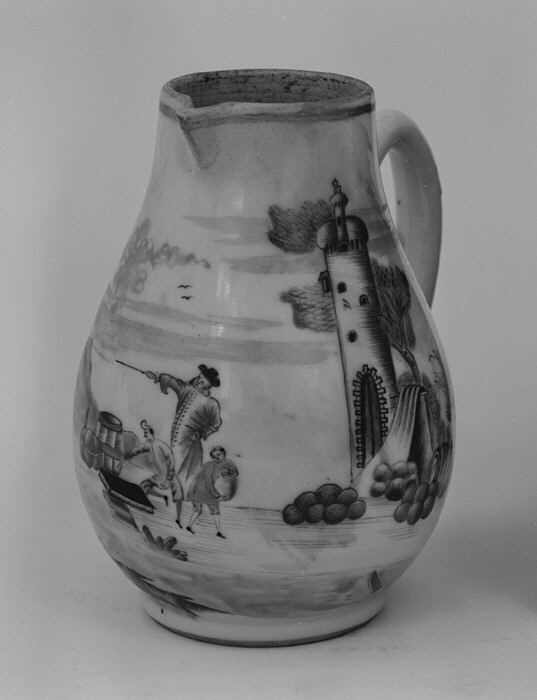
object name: hot milk jug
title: Hot milk jug (part of a service)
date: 1750-1770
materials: hard paste porcelain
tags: towers,men